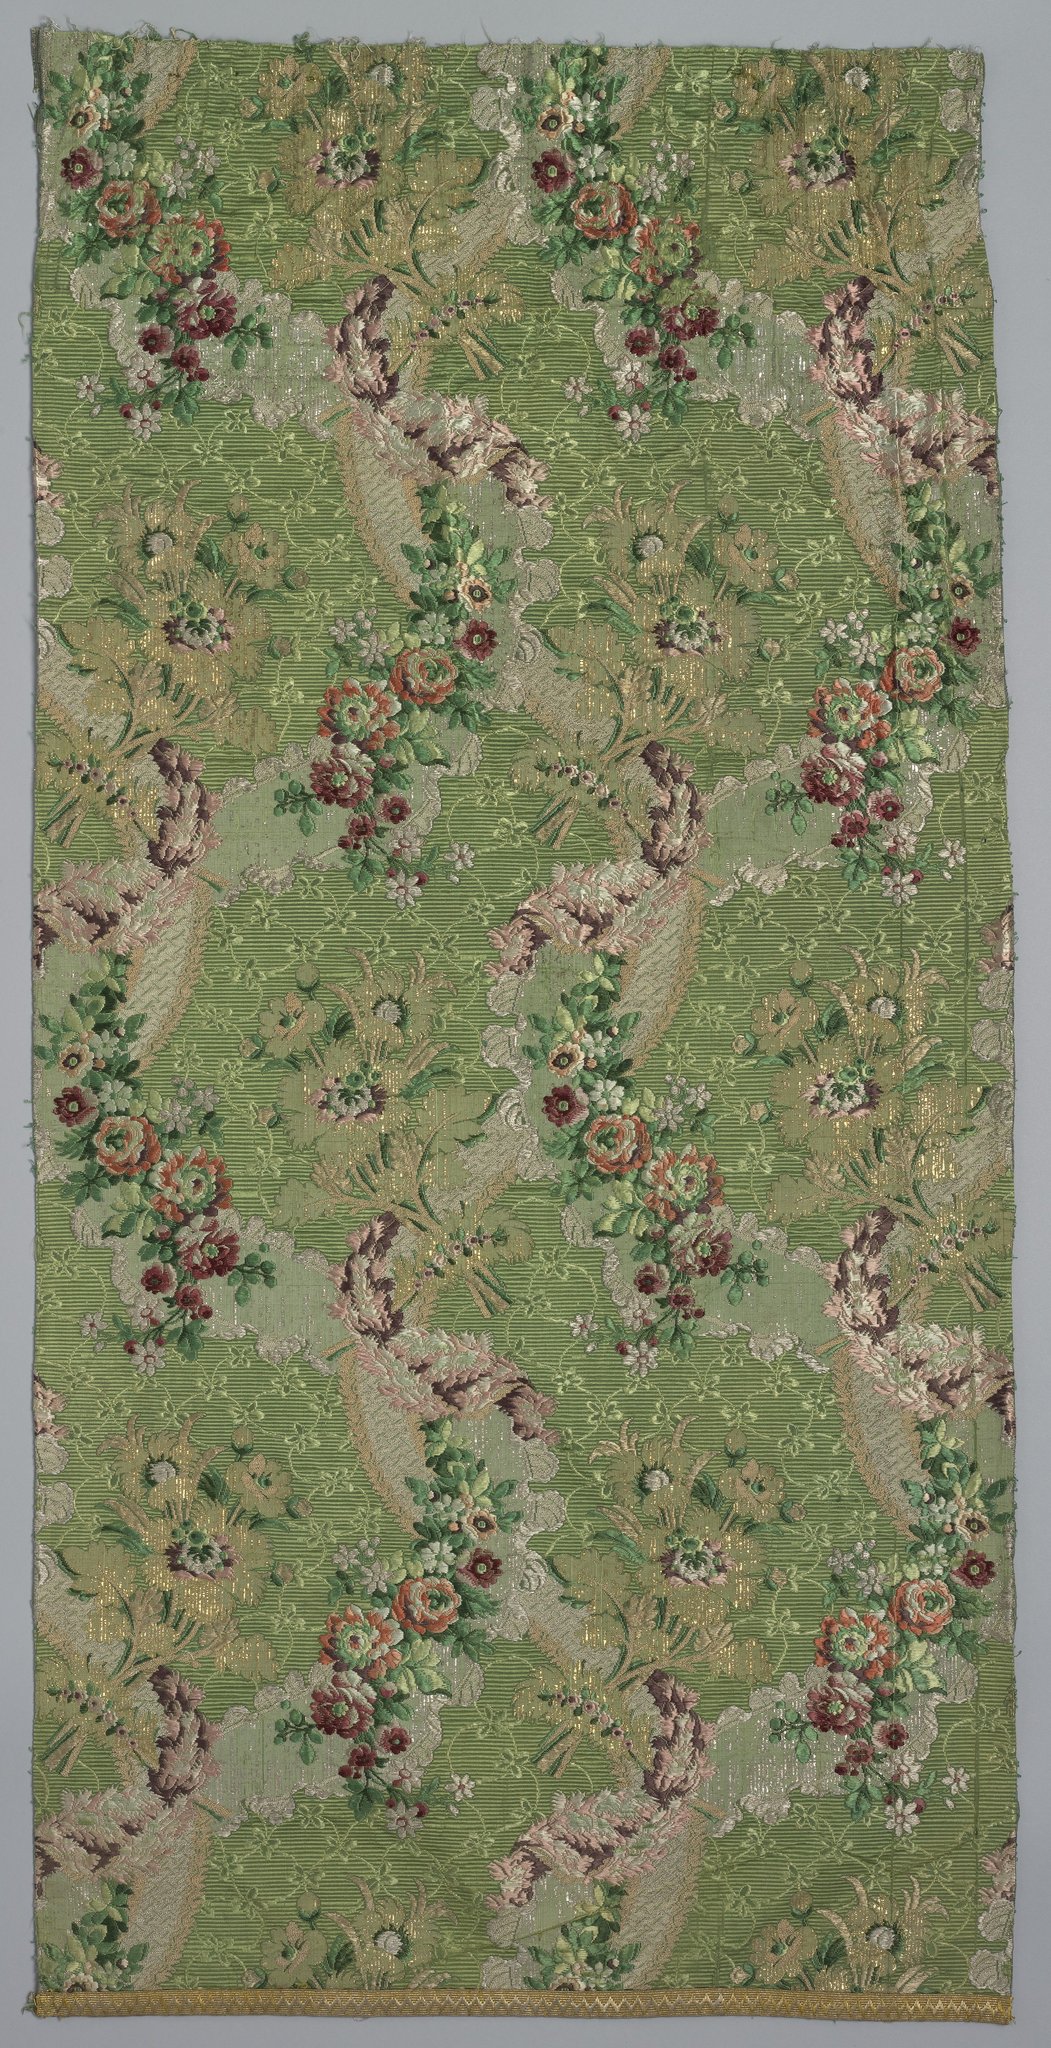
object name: length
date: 1701-1800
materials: metal thread, silk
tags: flowers